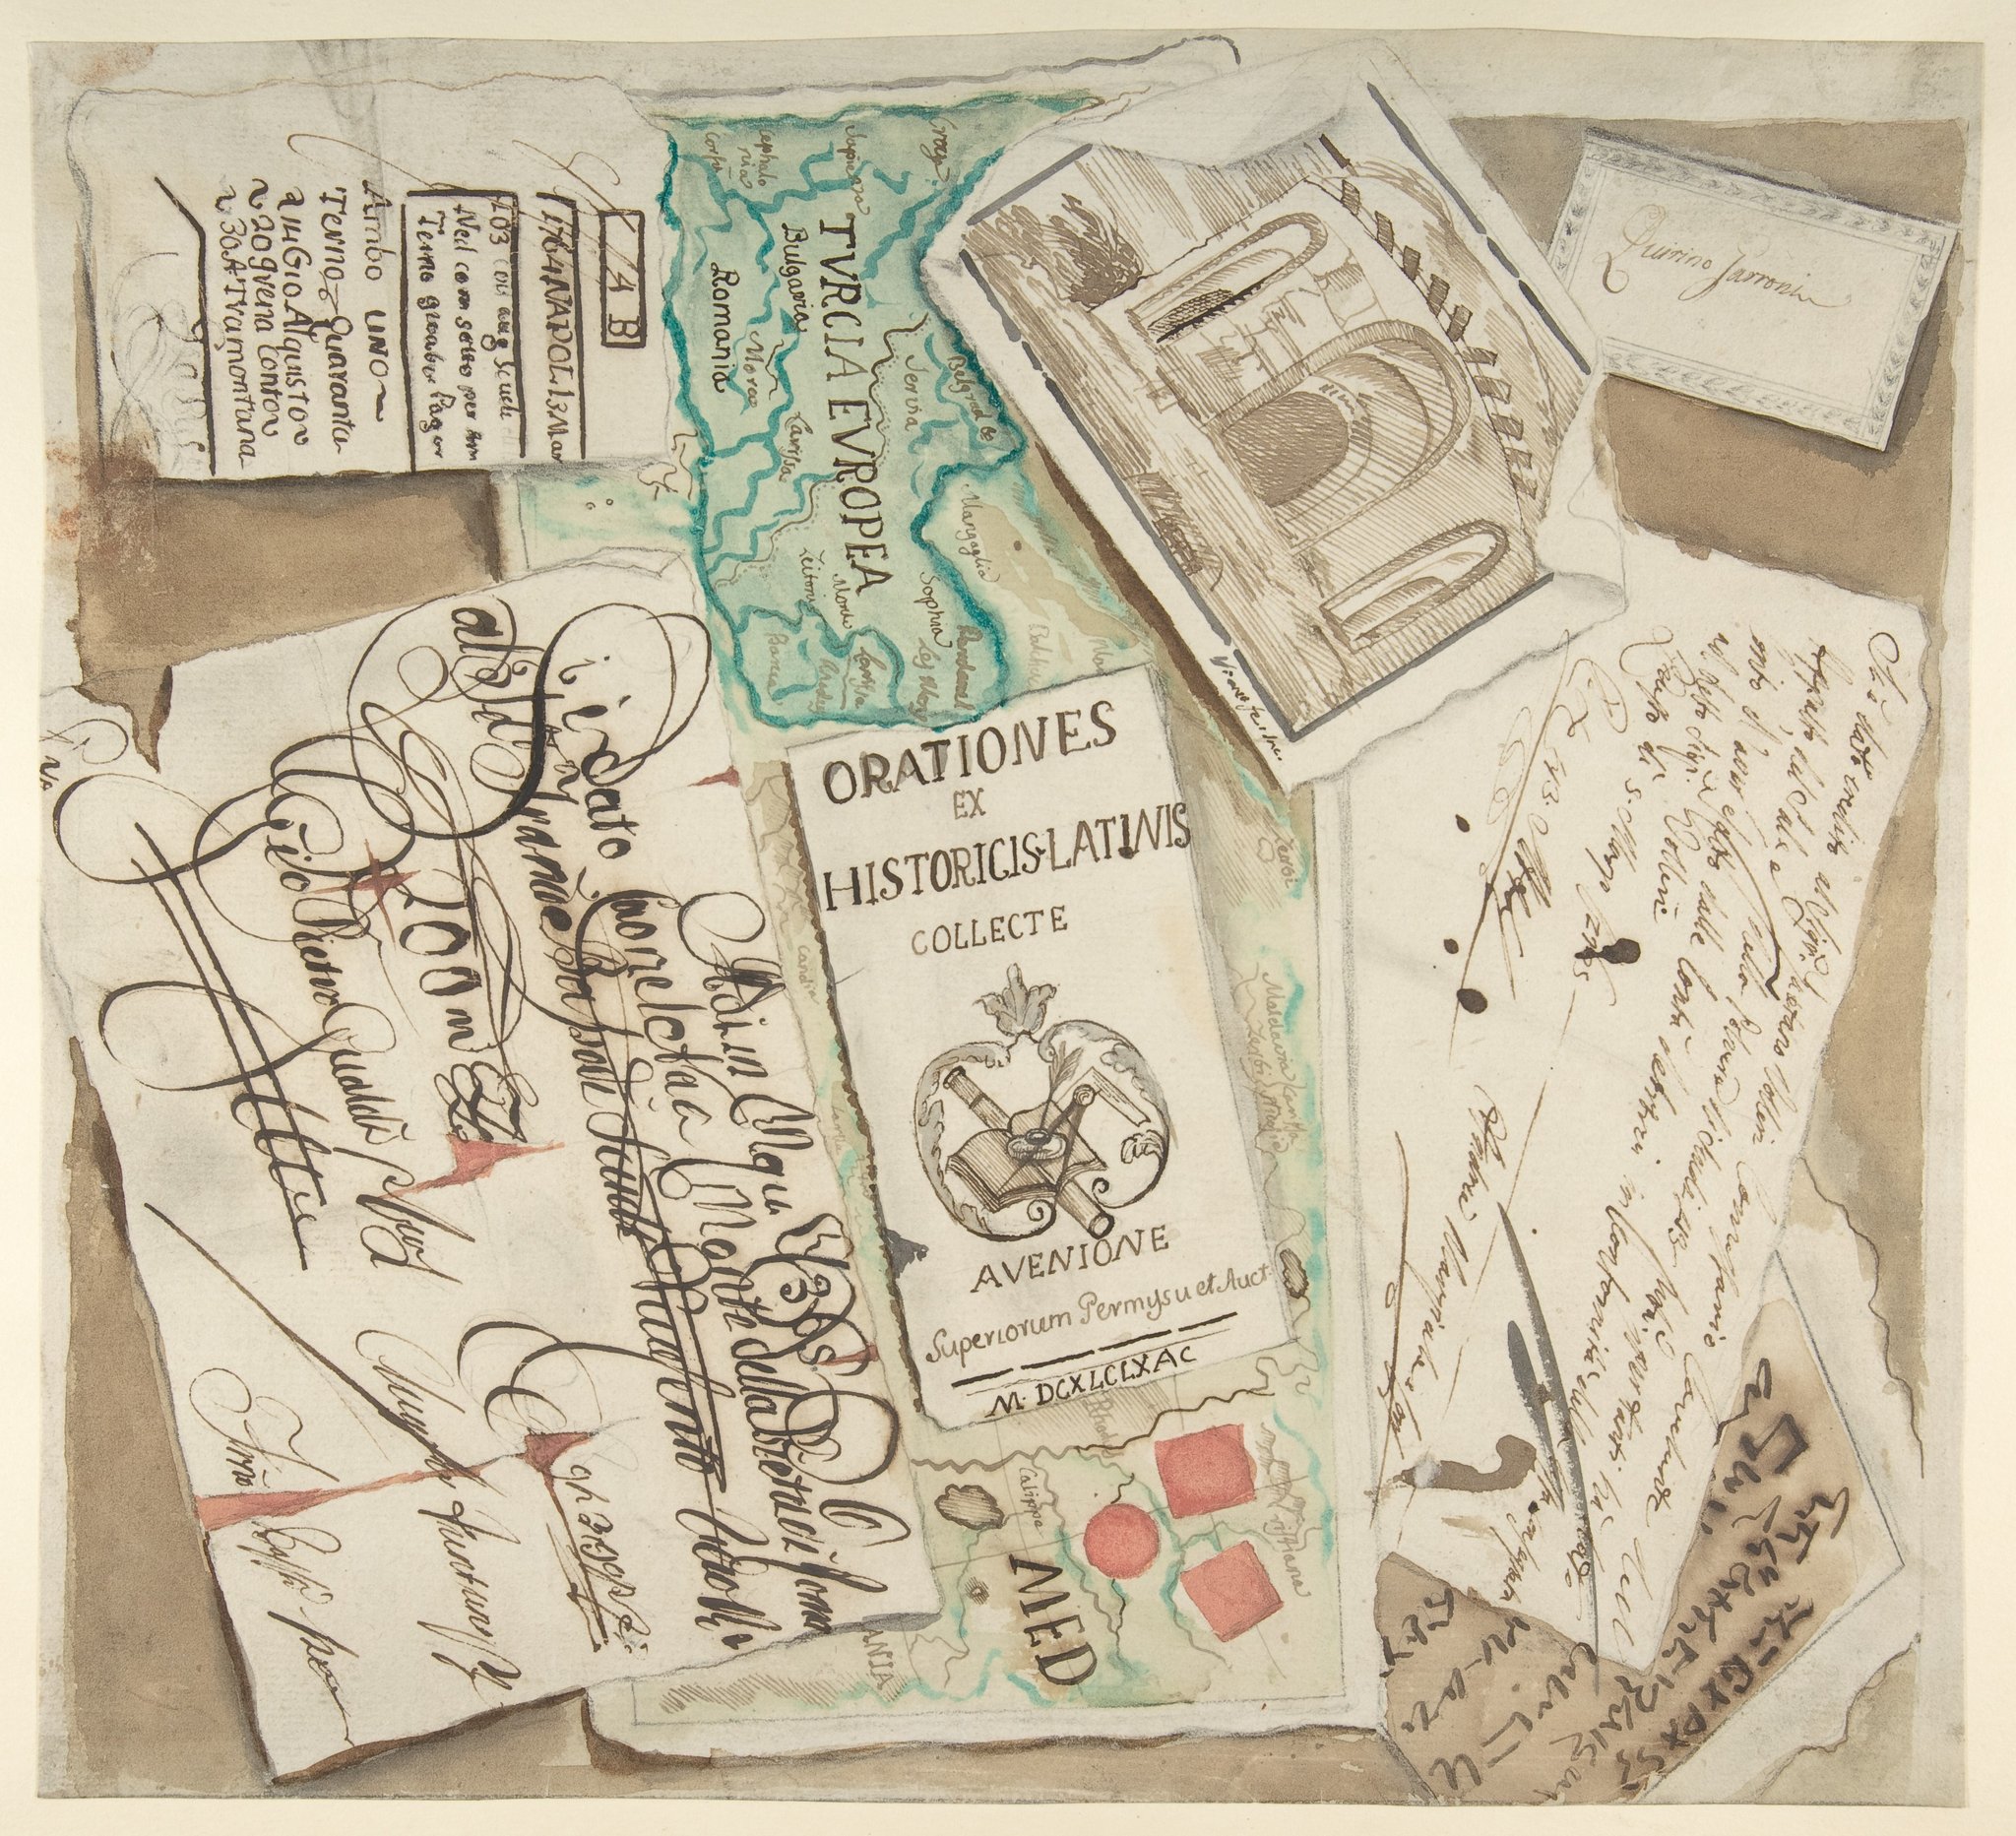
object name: drawing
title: Trompe l'Oeil Design Including Bills, Calling Cards, an Etching, a Map etc.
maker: anonymous, italian, 18th century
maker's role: artist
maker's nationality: italian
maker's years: 1700-1800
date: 1701-1800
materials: chalk, ink, paper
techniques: brush, pen, wash